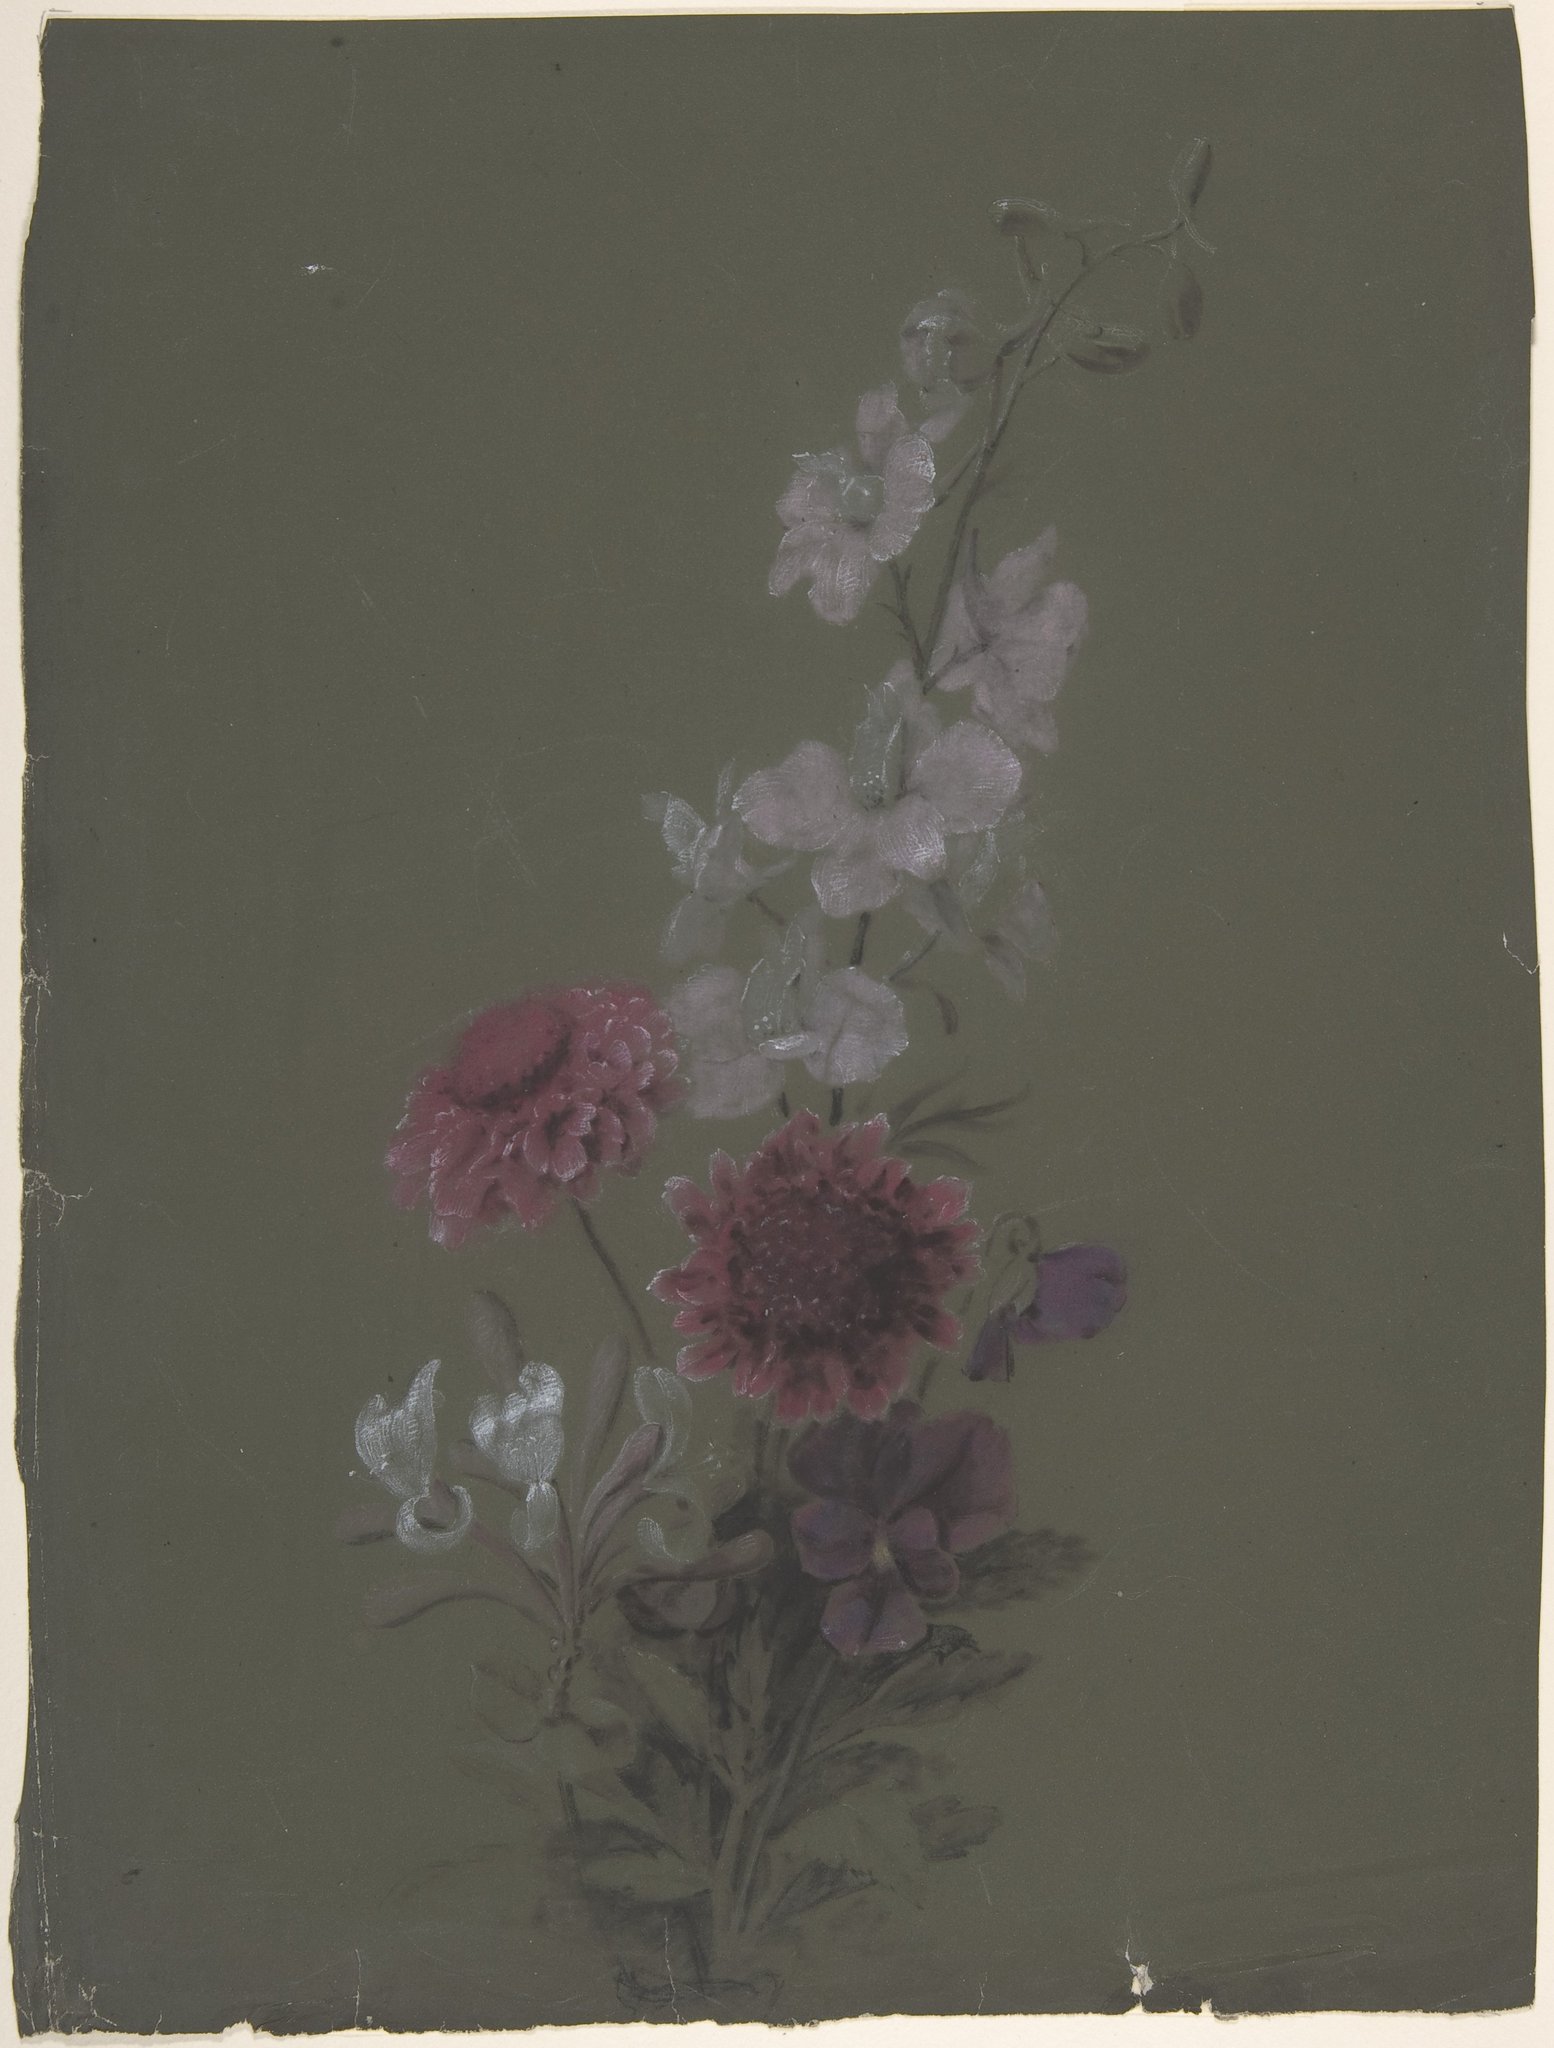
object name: drawing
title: Floral Design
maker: antoine berjon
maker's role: artist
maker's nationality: french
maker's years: 1754-1843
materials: chalk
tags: flowers